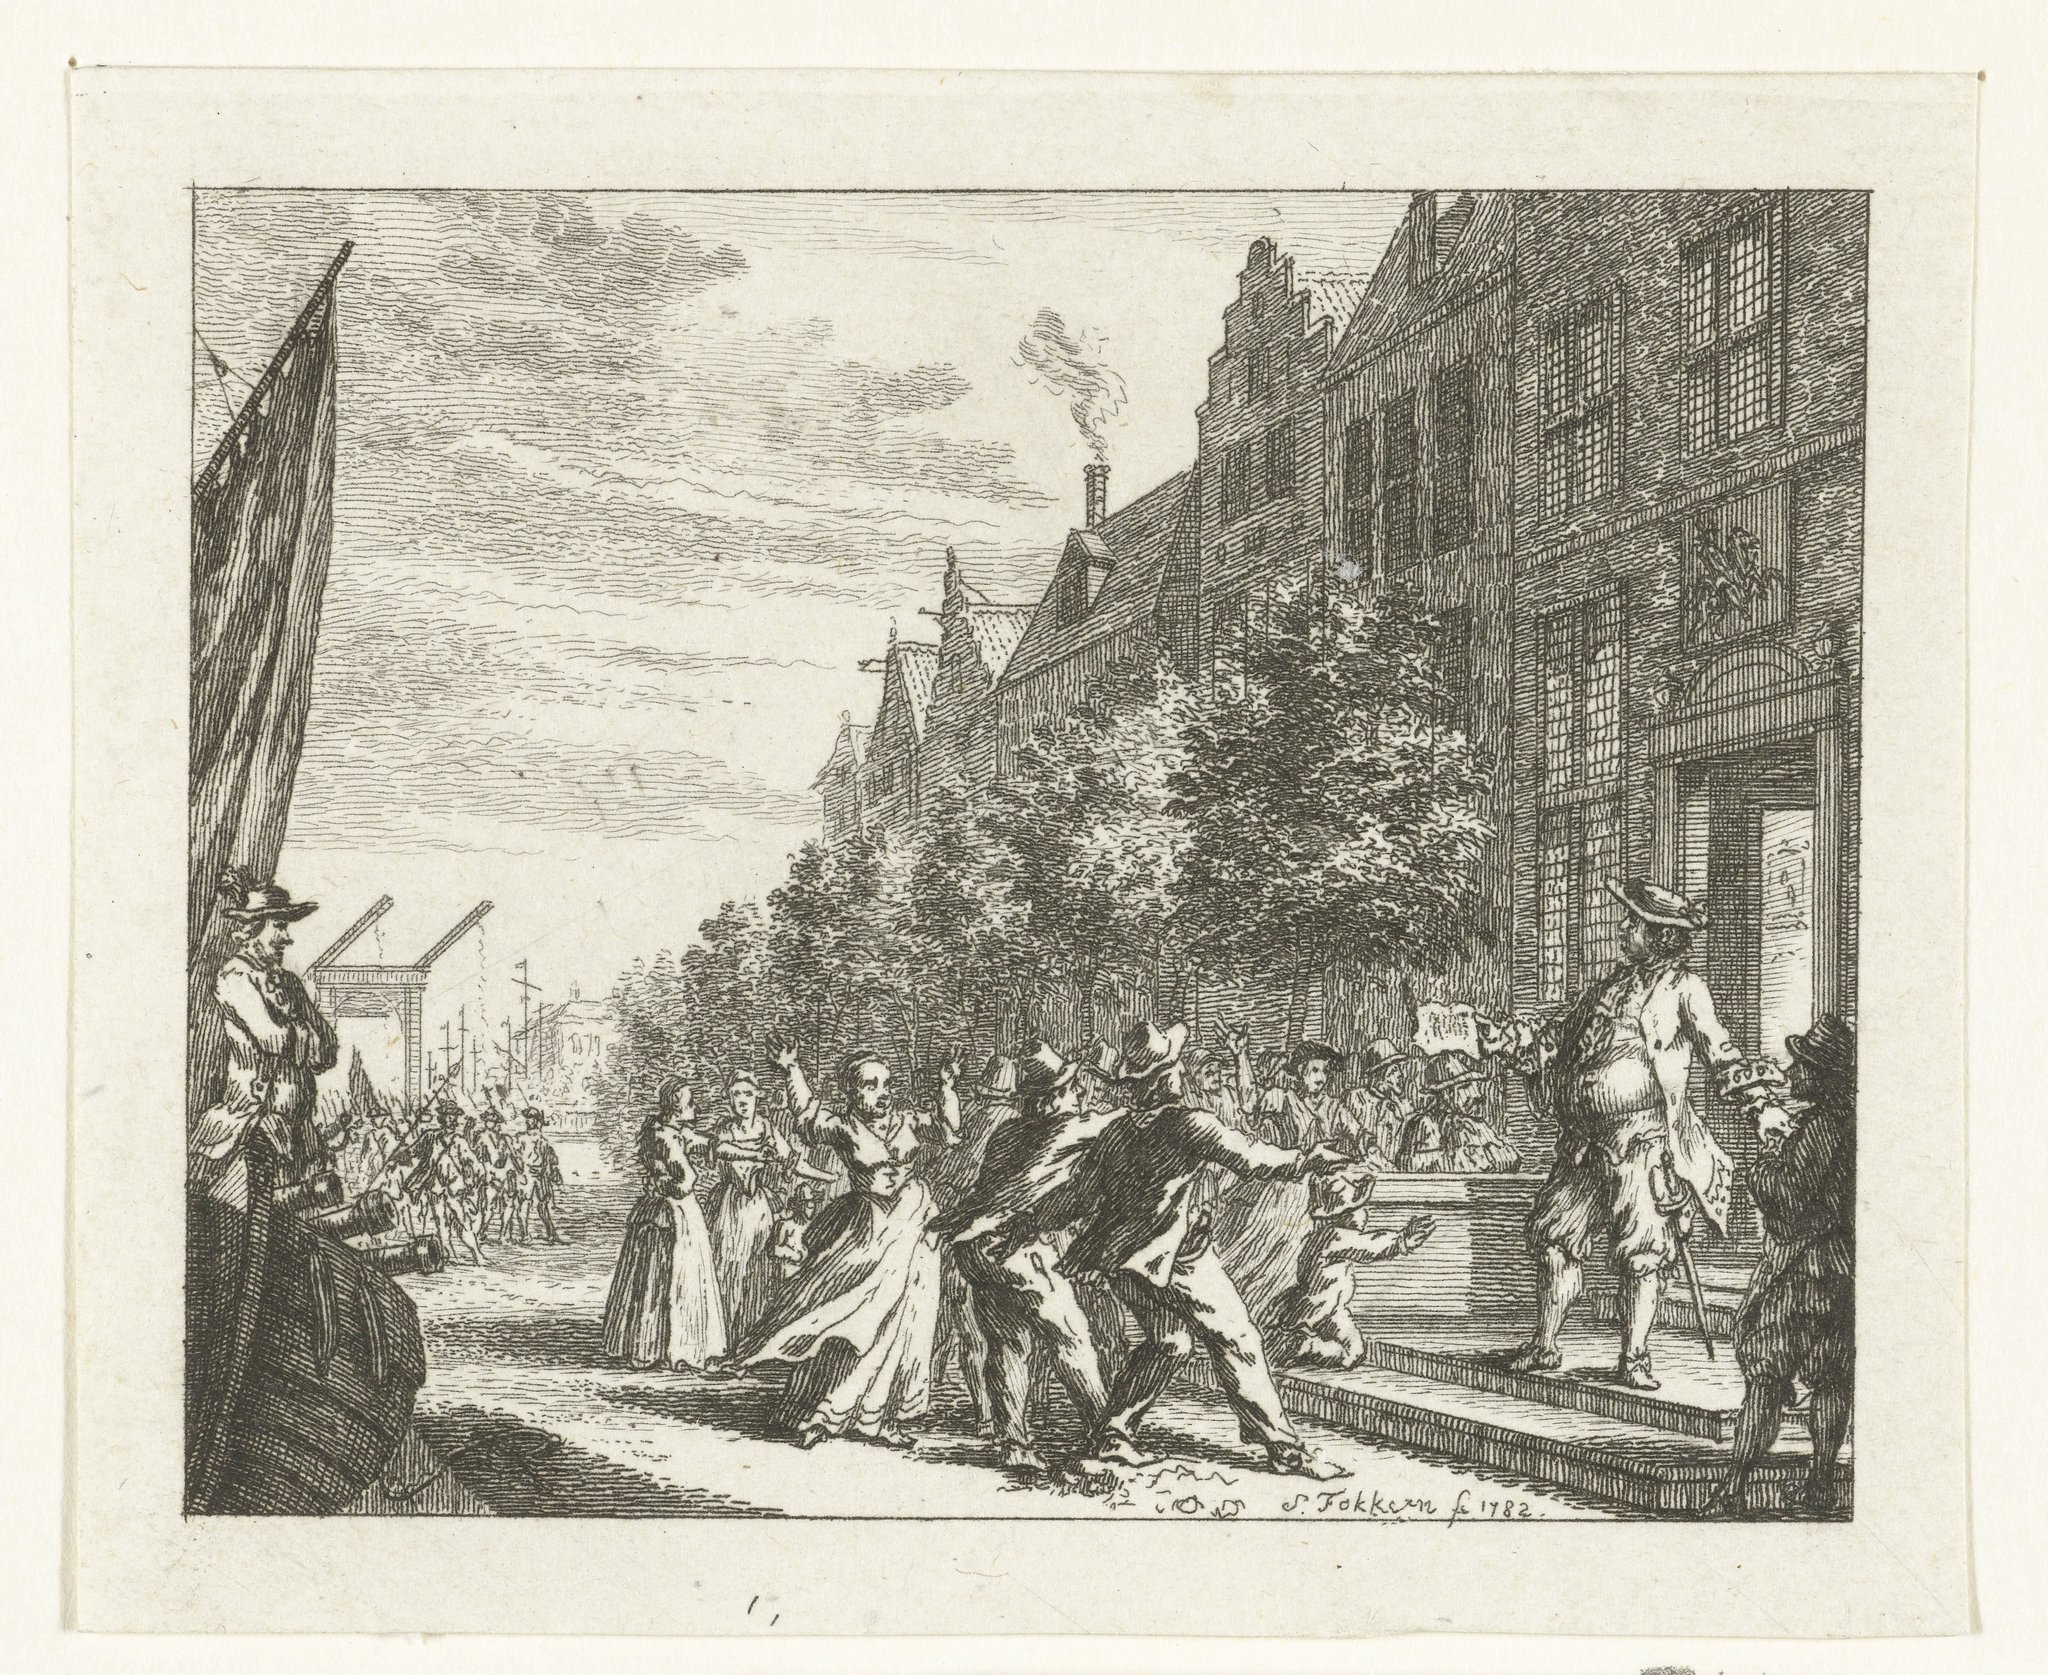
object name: print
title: Opstootje voor het huis van admiraal De Ruyter, 1672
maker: simon fokke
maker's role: draughtsman, print maker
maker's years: 1712-1784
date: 1782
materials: paper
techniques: etching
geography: northern netherlands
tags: flushing, michiel adriaenszoon de ruyter, street-fights, riots, amsterdam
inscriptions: date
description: Woedende menigte voor het huis van admiraal Michiel Adriaenszoon de Ruyter aan de Prins Hendrikkade te Amsterdam. Hij werd valselijk beschuldigd de vloot aan de Fransen te willen verraden, 6 oktober 1672.